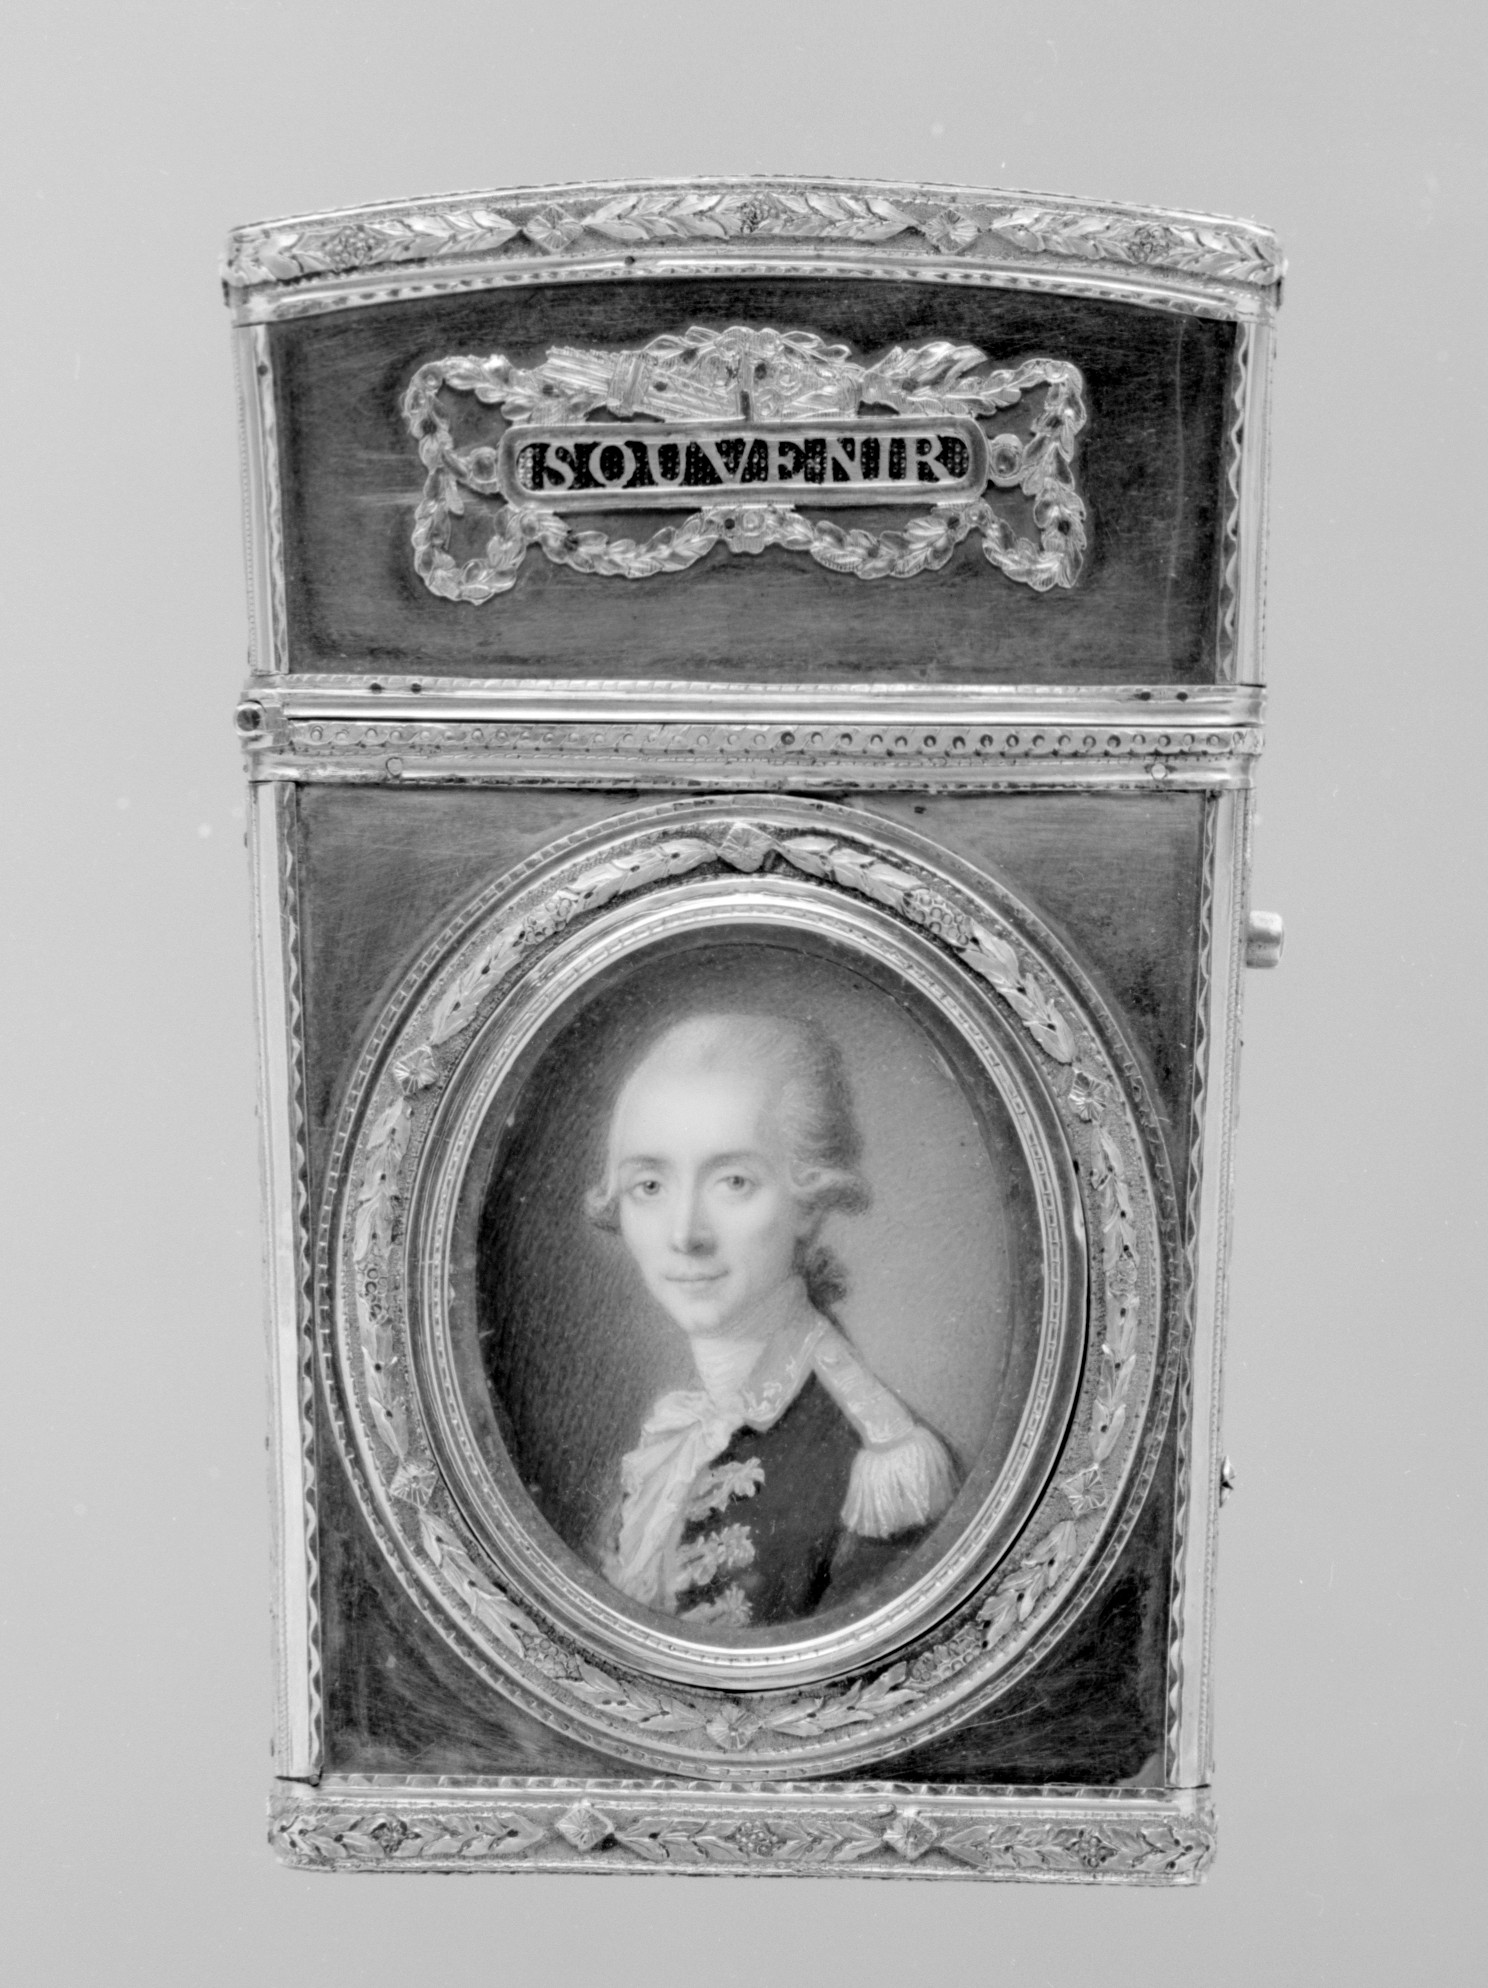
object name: souvenir, painting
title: Souvenir with portrait of a man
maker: pierre-andré barbier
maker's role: maker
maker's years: 1676-1776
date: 1778-1779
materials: gold, ivory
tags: men,portraits